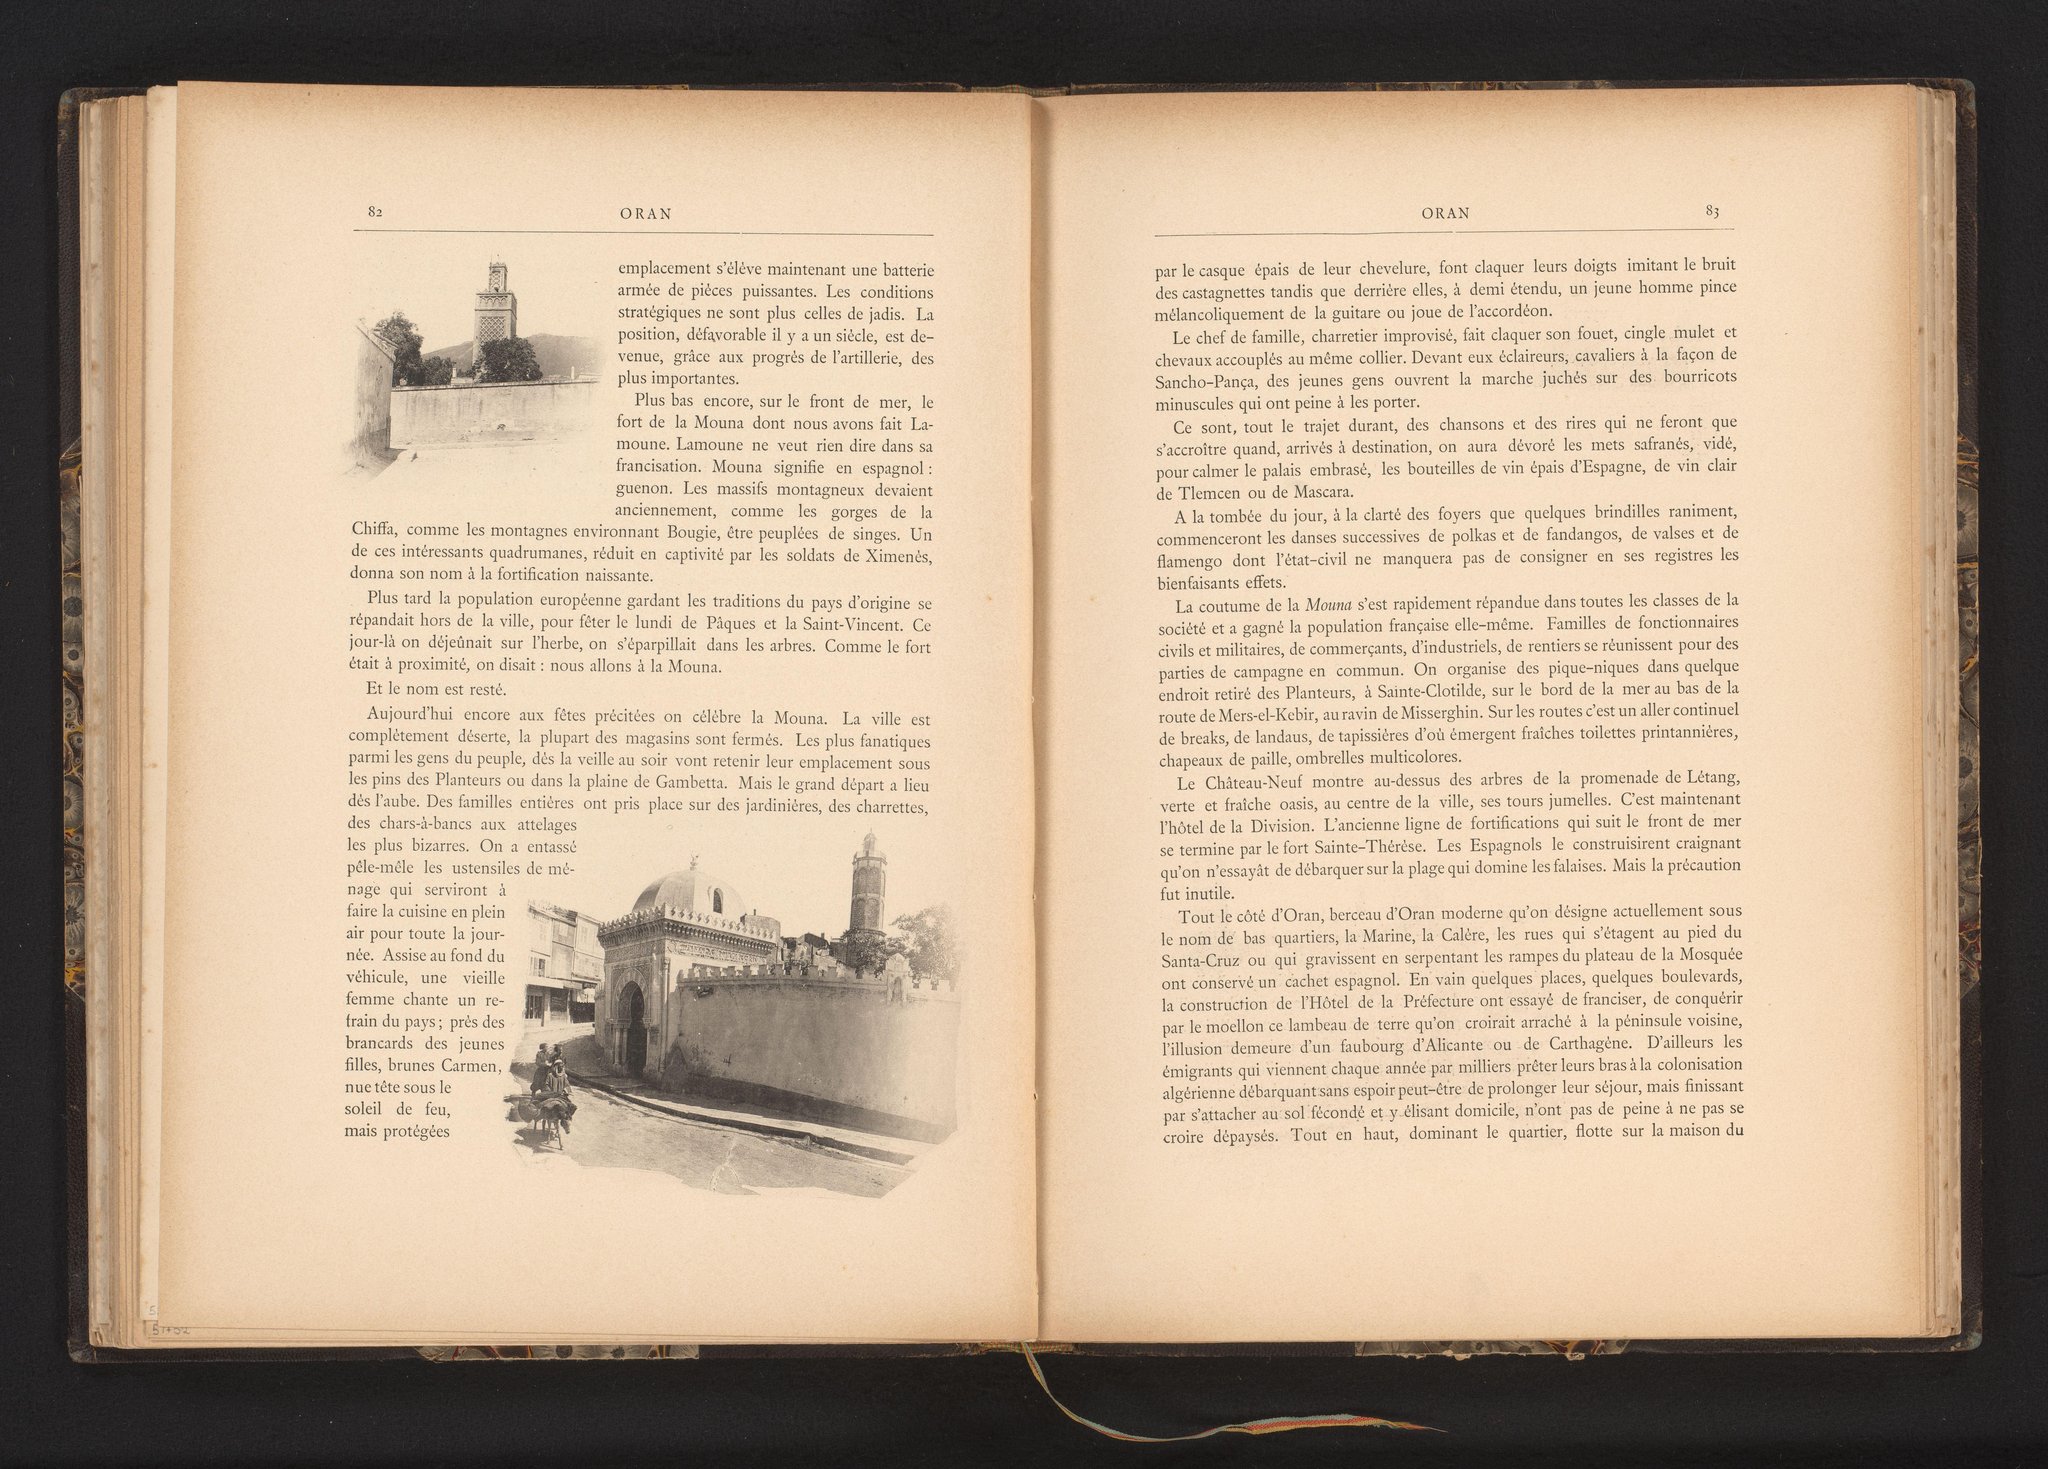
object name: photomechanical print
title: Gezicht op de Hassan Pasha moskee in Oran, Algerije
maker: jules gervais-courtellemont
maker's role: fotograaf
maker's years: 1863-1931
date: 1888-1893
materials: paper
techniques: photograph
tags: temple, shrine ~ islam, mohammedanism, street